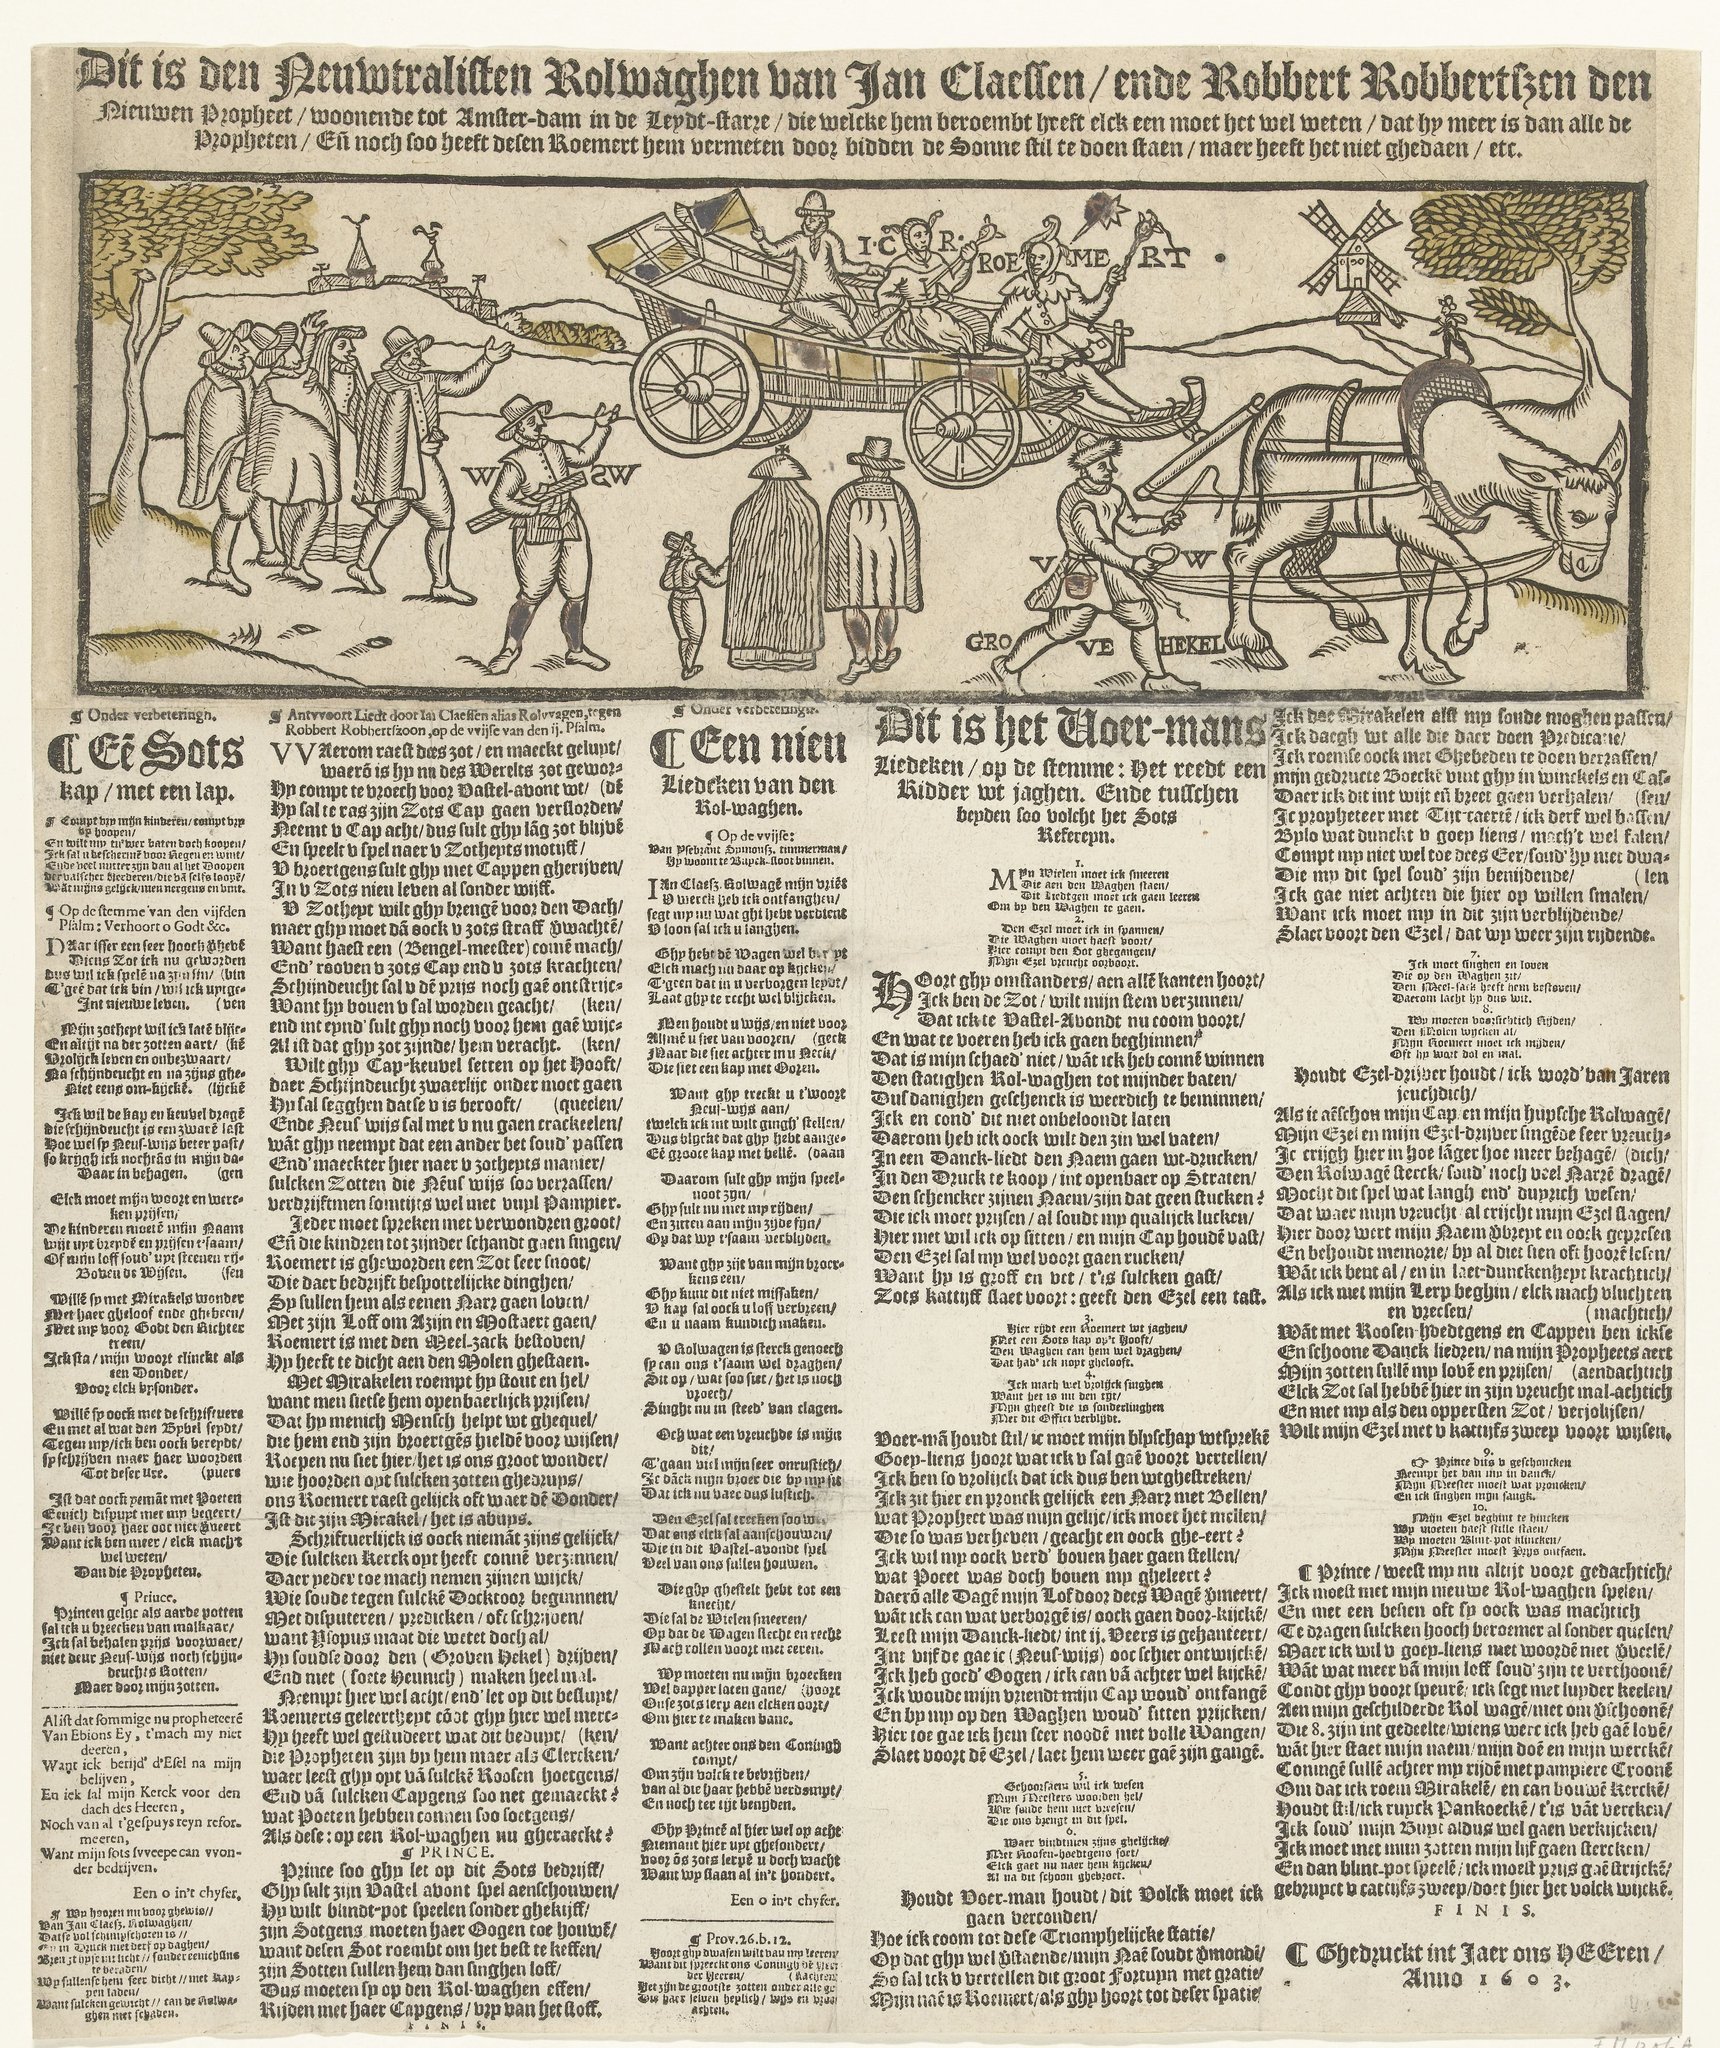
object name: print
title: De Neutralisten Rolwagen, 1603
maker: Anonymous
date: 1603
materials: paper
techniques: letterpress printing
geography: northern netherlands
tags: court jester, court fool, comet, (farm) wagon, freight wagon, cart, amsterdam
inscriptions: date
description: De Neutralisten Rolwagen, 1603. Spotprent op Jan Claesz Rolwaghen en de visioenen en profetieën van Robbert Robbertsz Le Canu. Heeft betrekking op de gescheidenis van de Doopsgezinden in Amsterdam rond 1600. Blad met bovenaan een grove houtsnede van een rolwagen (kar) met een nar op de bok, achterin zitten Rolwaghen en Robbert Robbertsen. De wagen wordt getrokken door een muilezel en geleid door een ezeldrijver met een grove hekel. Links toeschouwers. In de hemel een staartster die verwijst naar de Leidstar (het huis waar Le Canu woonde) en naar de bewering van Robbertsen dat de zon zou stilstaan als bewijs voor de waarheid van zijn beweringen. Onder de voorstelling 5 kolommen met verschillende liedjes in het Nederlands over de dwaasheid van de hoofdfiguren.